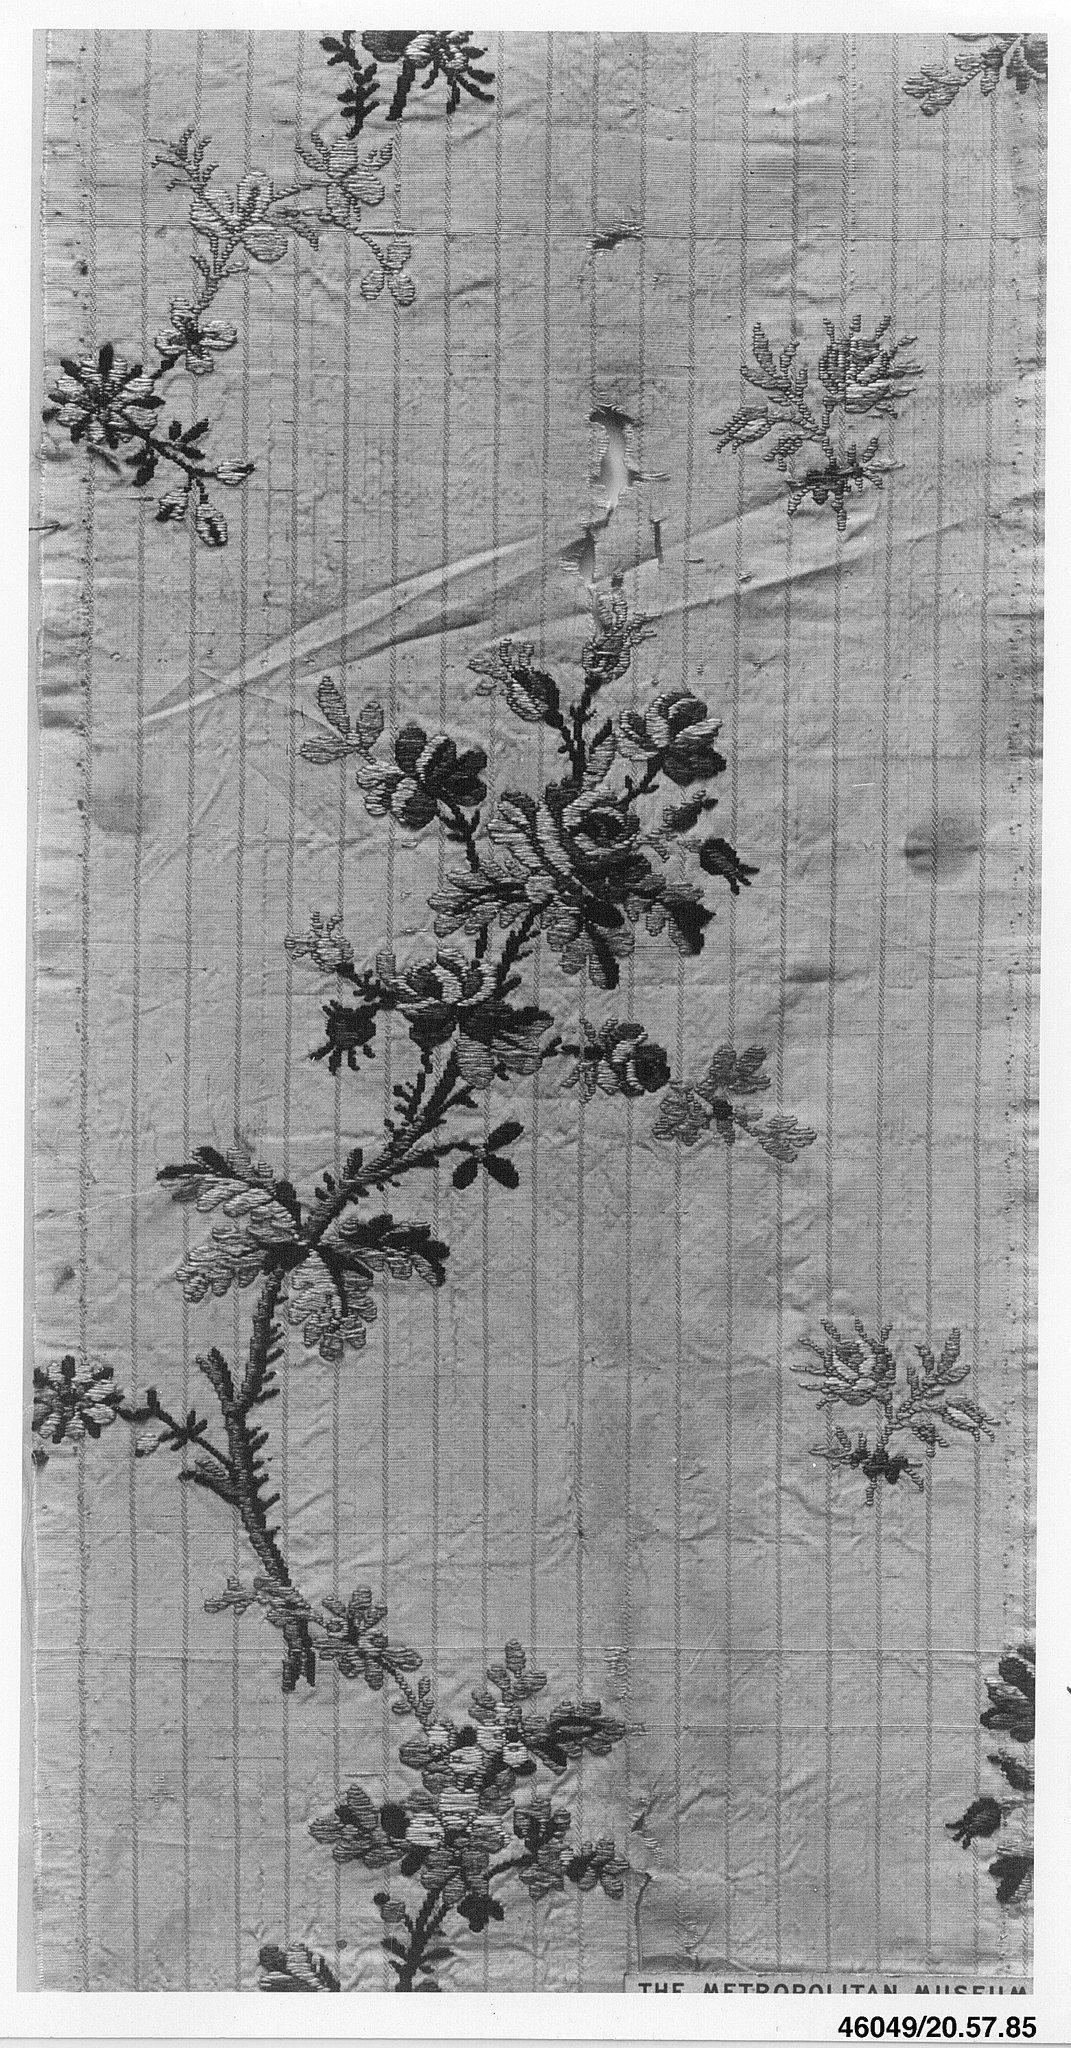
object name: piece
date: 1776-1800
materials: silk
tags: flowers,leaves